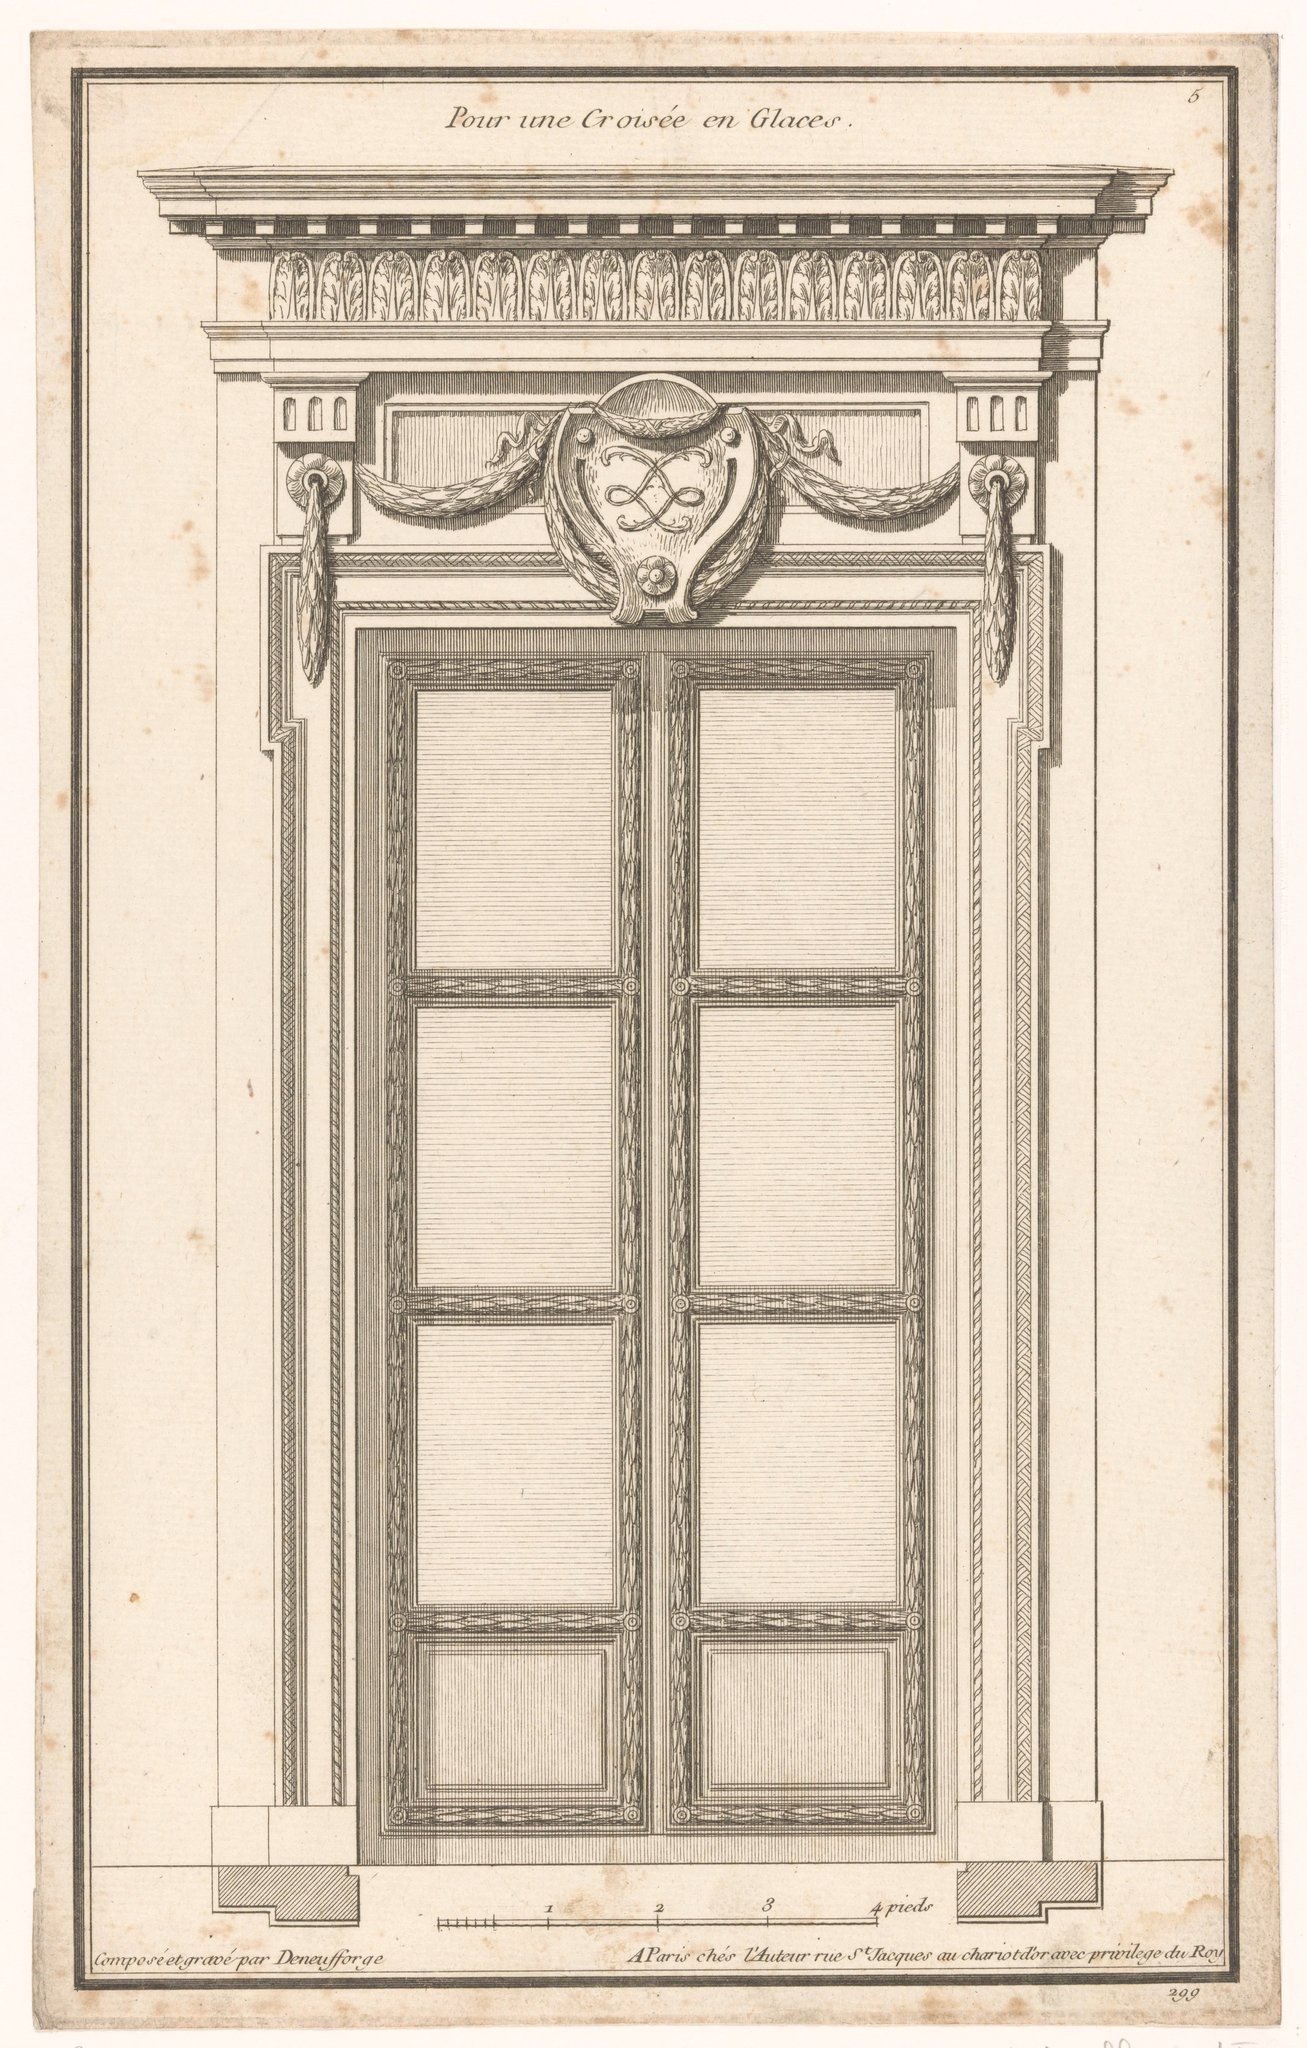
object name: ornament print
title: Pour une Croisée en Glaces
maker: jean françois de neufforge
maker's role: print maker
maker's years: 1714-1791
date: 1763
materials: paper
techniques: etching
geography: paris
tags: window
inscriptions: collector's mark: Lugt 2228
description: Een kruisvenster met bladmotieven en aan de bovenzijde een rocaille schild met guirlandes en een lijst met acanthusbladeren. Prentnummer 299.